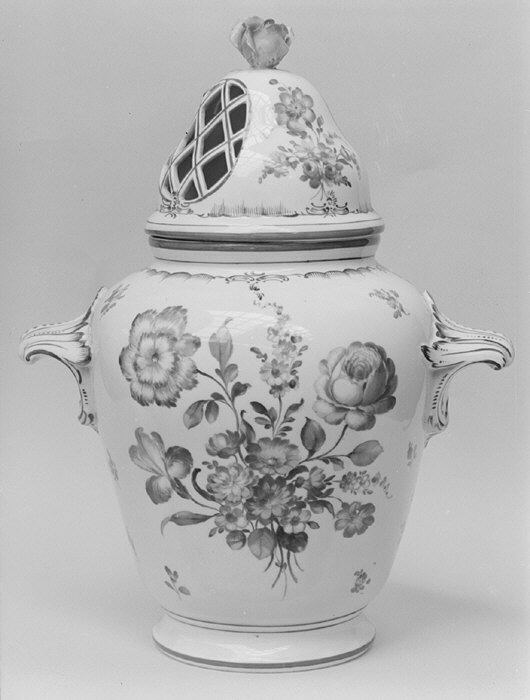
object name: potpourri vase with cover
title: Potpourri vase with cover (one of a pair)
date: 1801-1900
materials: hard paste porcelain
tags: flowers